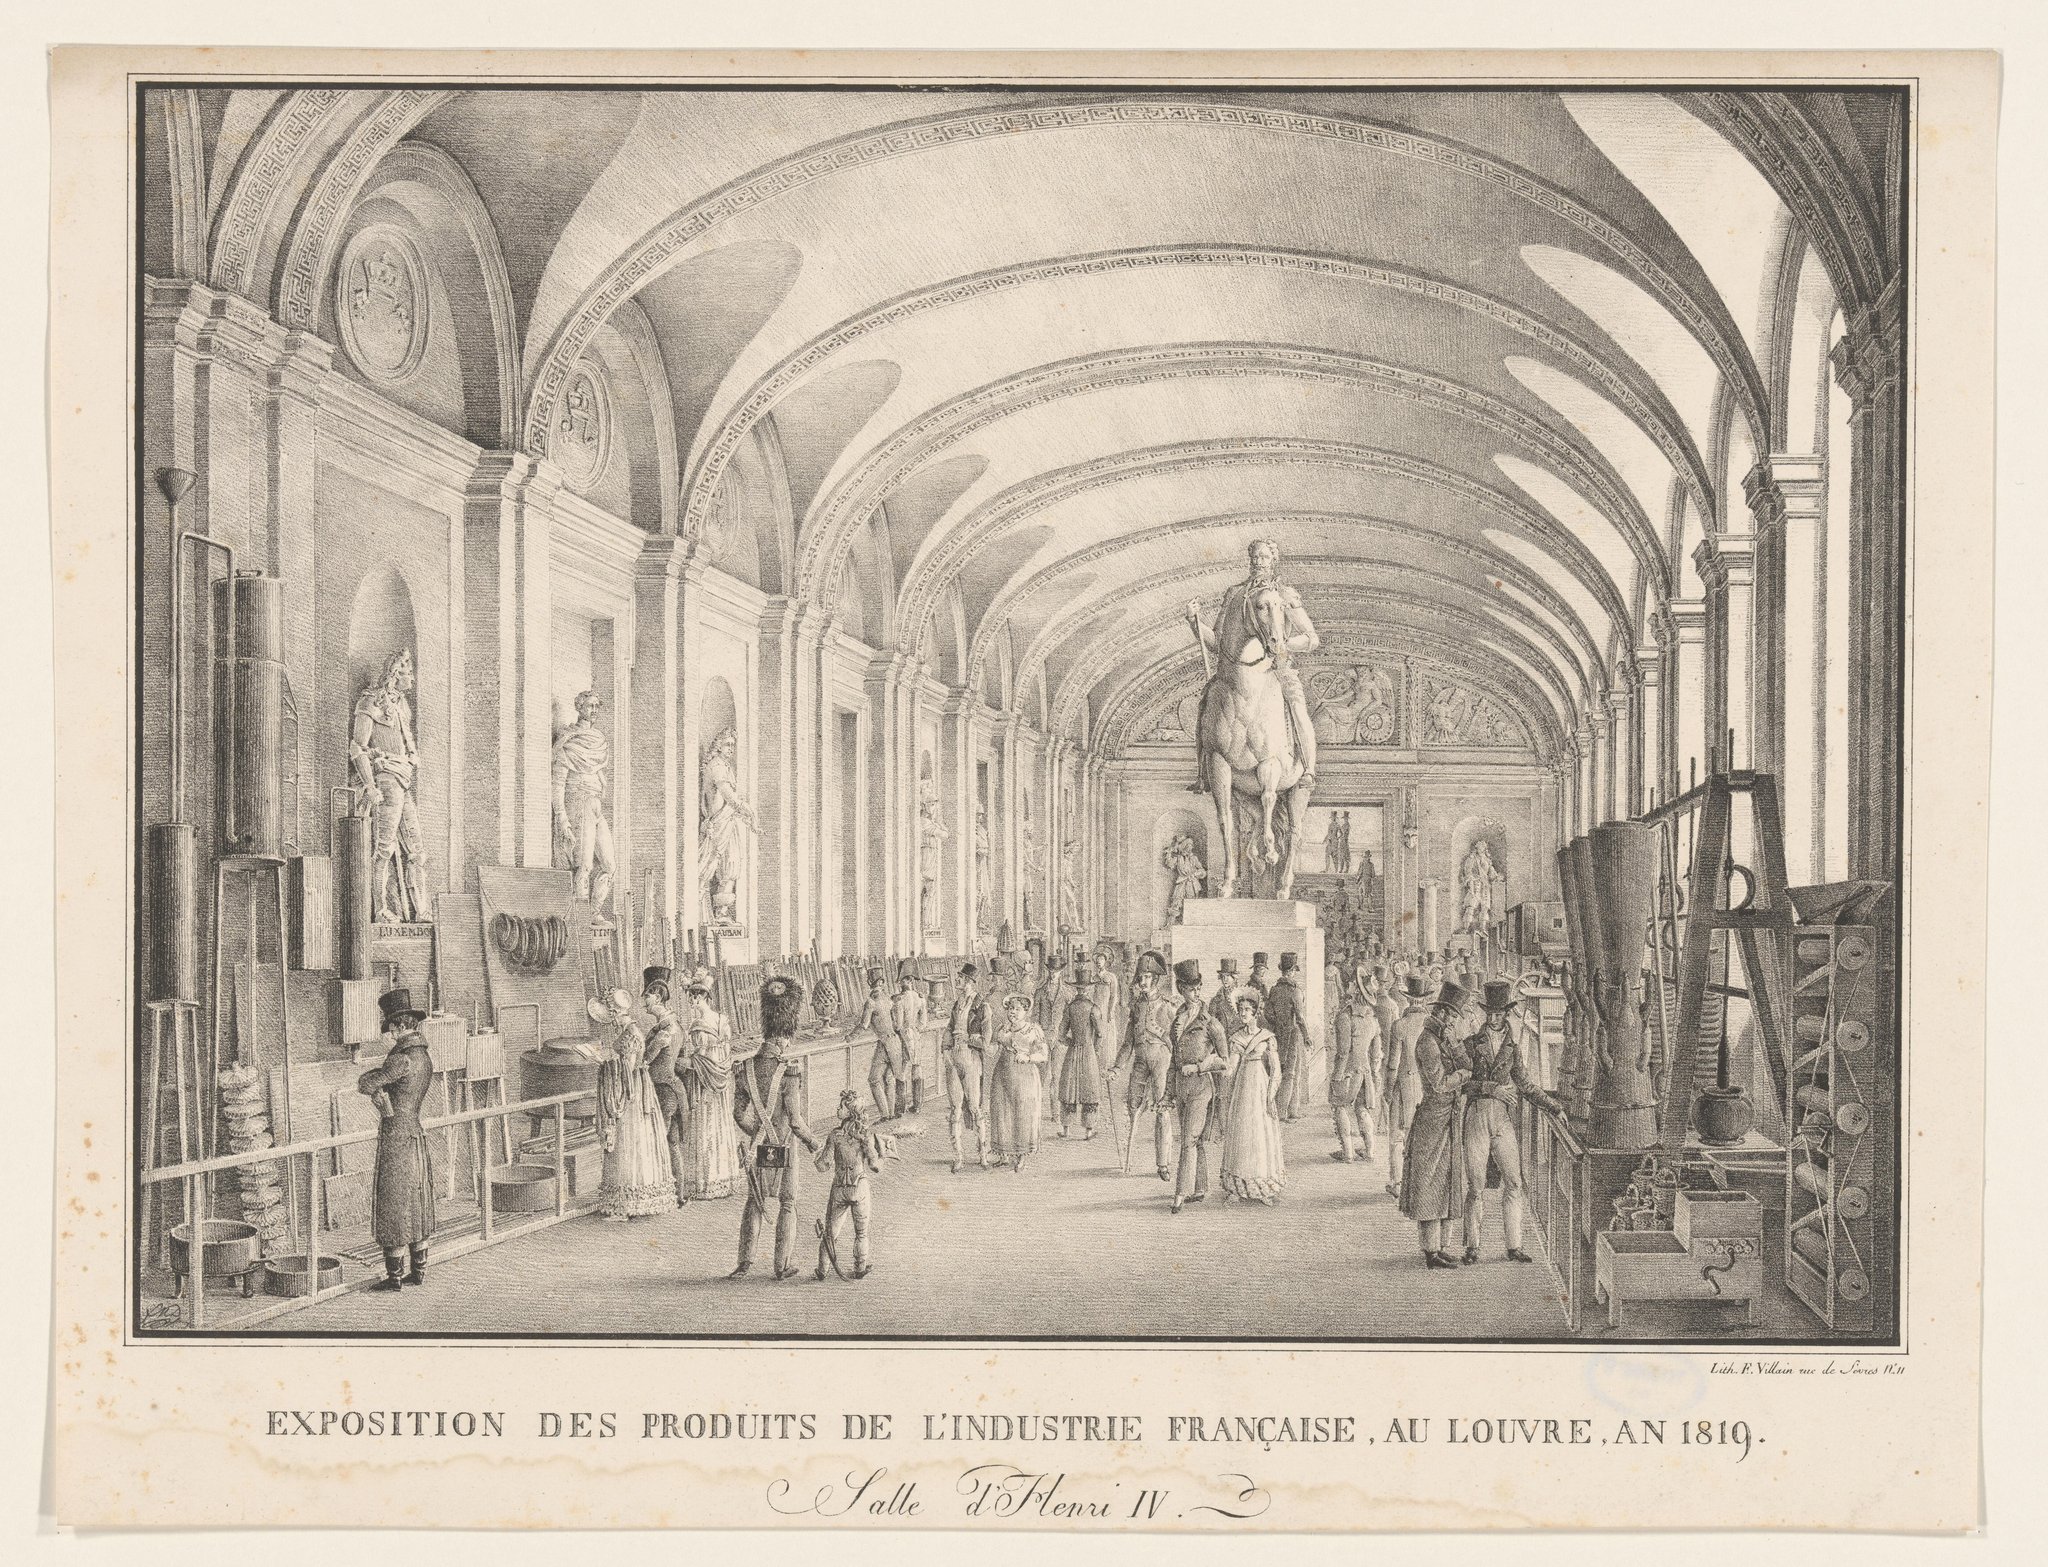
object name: print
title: Tentoonstelling van kunstnijverheidsproducten in het Louvre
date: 1820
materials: paper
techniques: lithograph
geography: paris